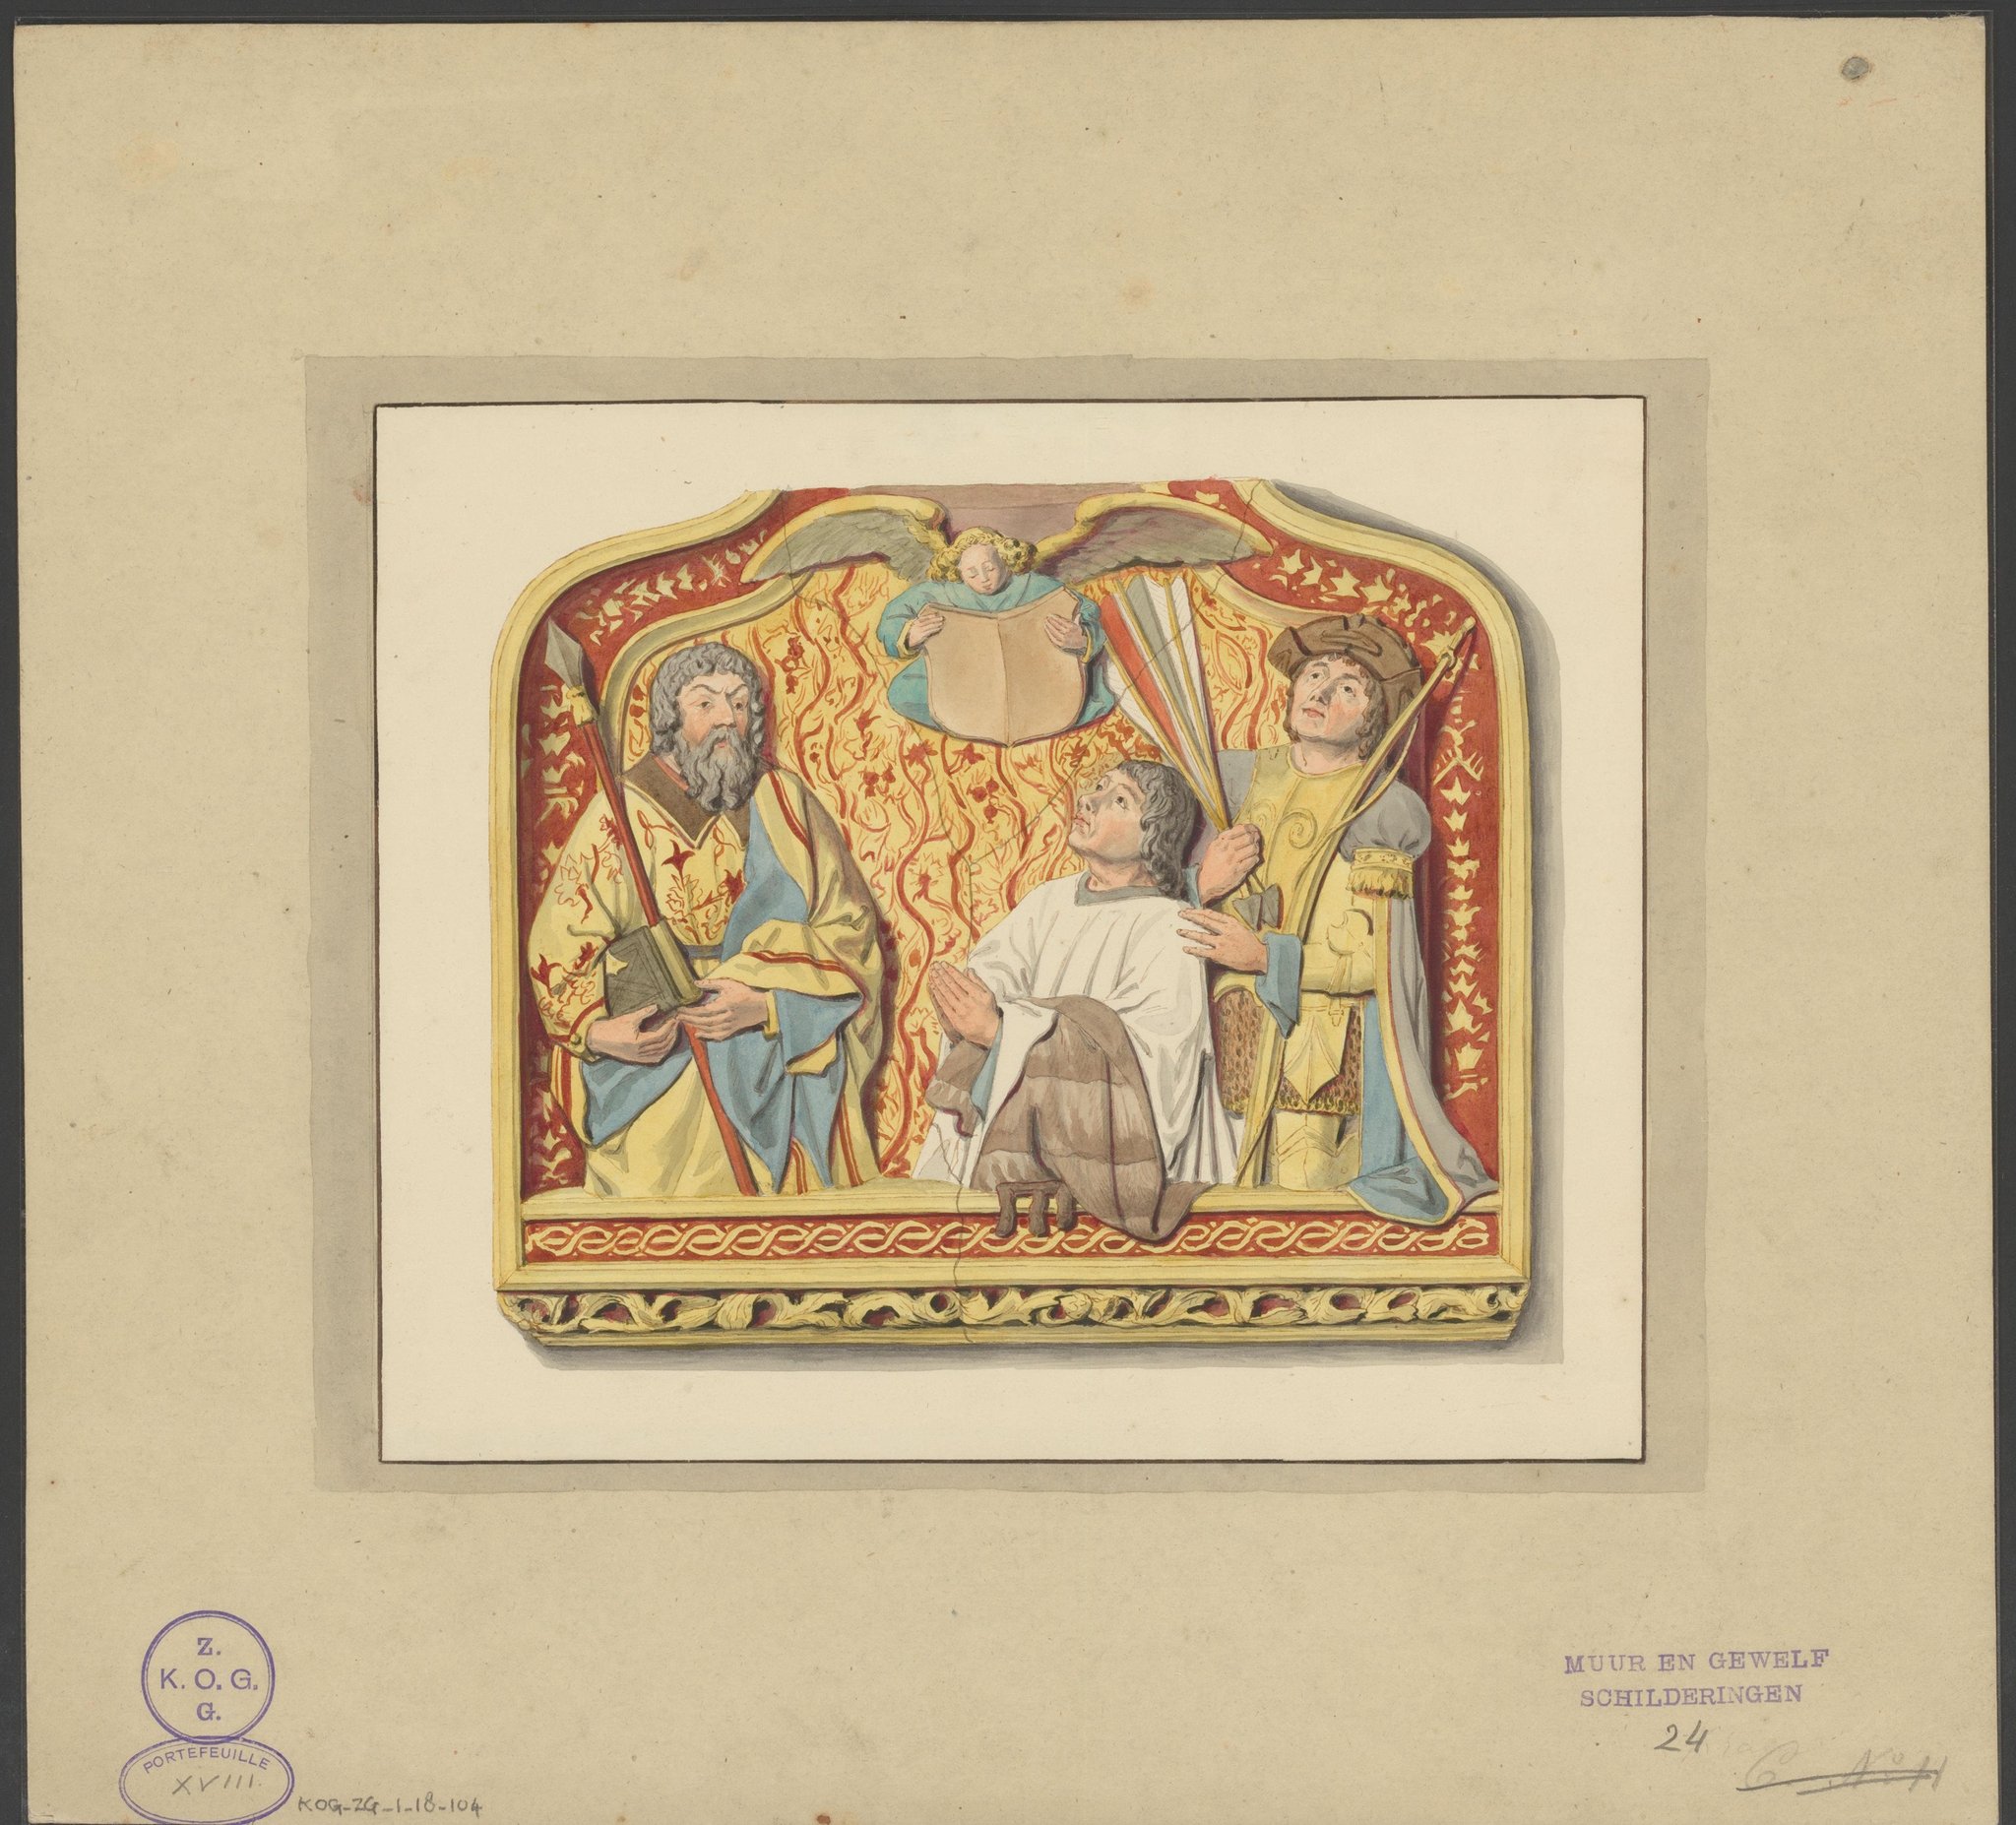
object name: drawing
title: Muurschildering met mecenas, Longinus en Sebastiaan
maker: Anonymous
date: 1800-1899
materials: ink, paper, pencil, watercolor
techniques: brush, pen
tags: female angels, the martyr sebastian; possible attributes: arrow(s), bow, tree-trunk, the soldier longinus (the centurion) of caesarea; possible attributes: lance, pyx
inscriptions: stamp, collector's mark: Lugt 1641, stamp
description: Onderwerpsrubrieken binnen de Atlas Zeden en Gewoonten: Schoone kunsten, Muur- en gewelfschilderingen.